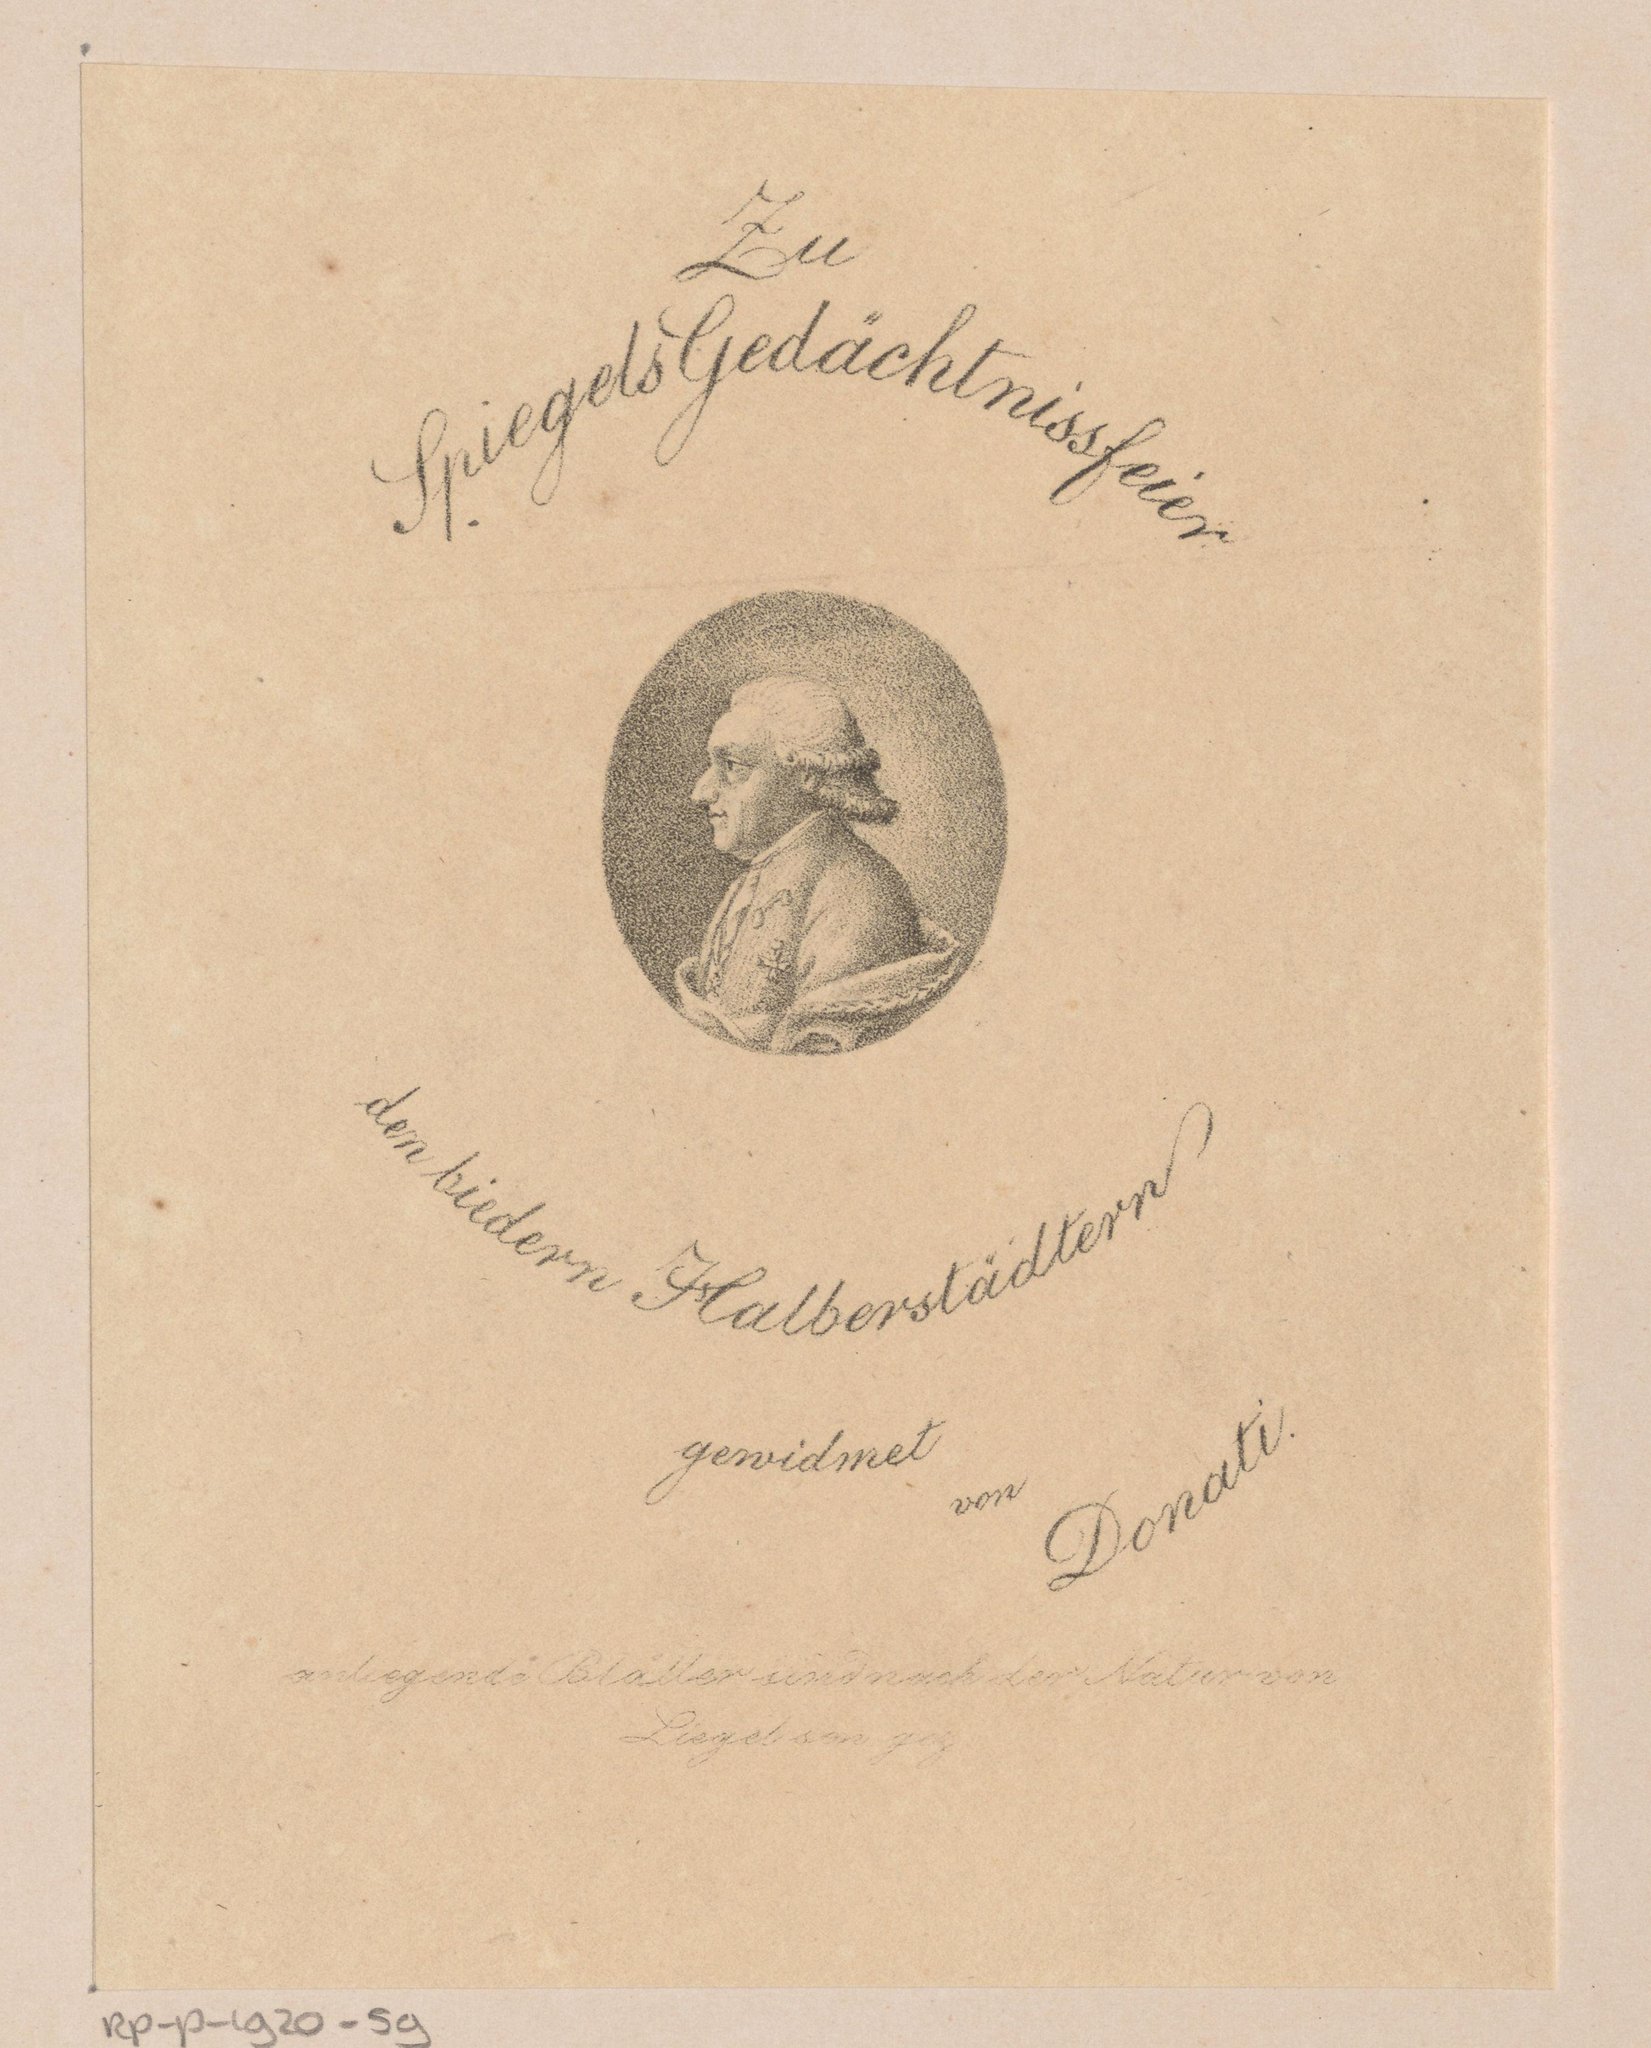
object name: print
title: Portret van Ernst Ludwig von Spiegel zum Diesenberg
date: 1798-1899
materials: paper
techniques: lithograph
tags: theologian, historical persons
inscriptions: collector's mark: Lugt 2228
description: Met eenregelig onderschrift in het Duits.